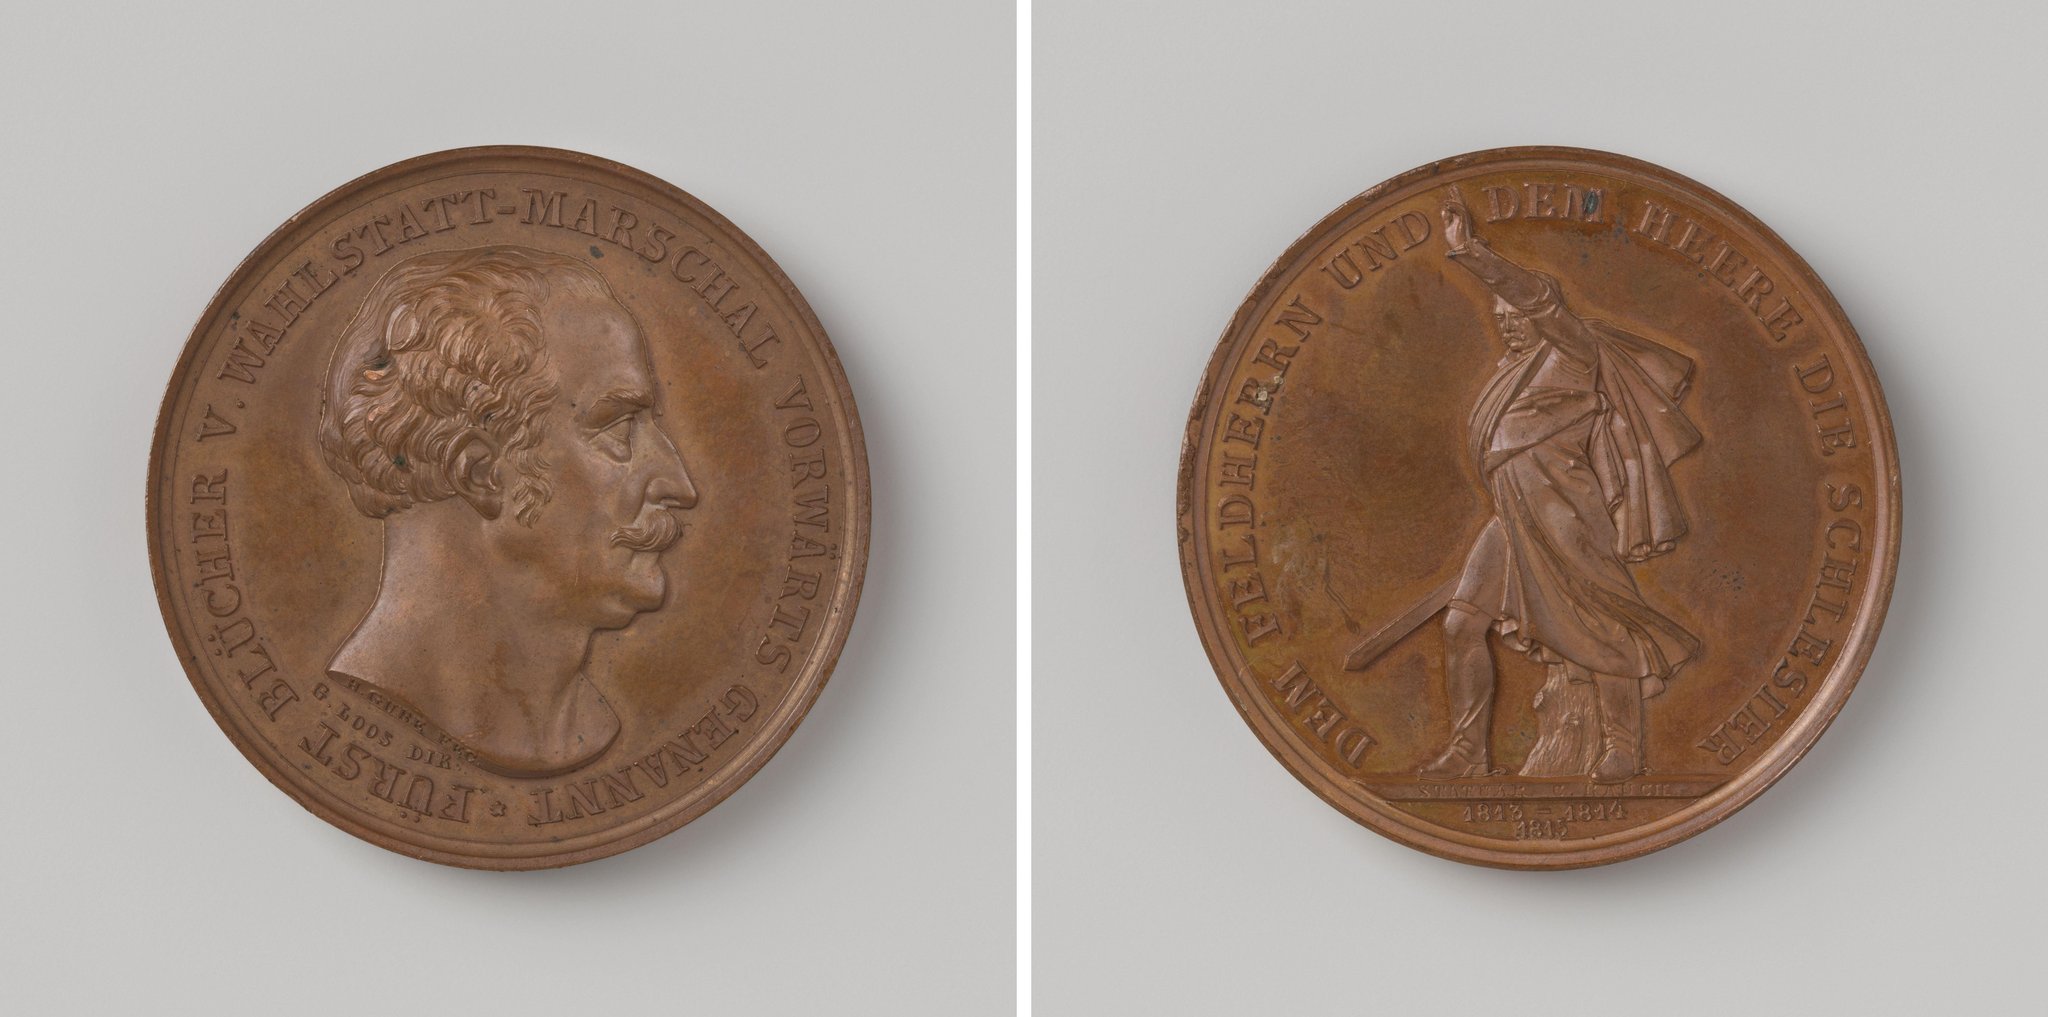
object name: history medal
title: Oprichting van een standbeeld voor Gebhard Leberecht, vorst Blucher von Wahlstatt te Breslau door Christian Daniel Rauch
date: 1820-1830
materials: bronze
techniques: striking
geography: berlin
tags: christian daniel rauch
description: Bronzen penning. Voorzijde: borststuk man binnen omschrift. Keerzijde: standbeeld van man met geheven linkerarm en zwaard in rechterhand binnen omschrift; afsnede: jaartallen